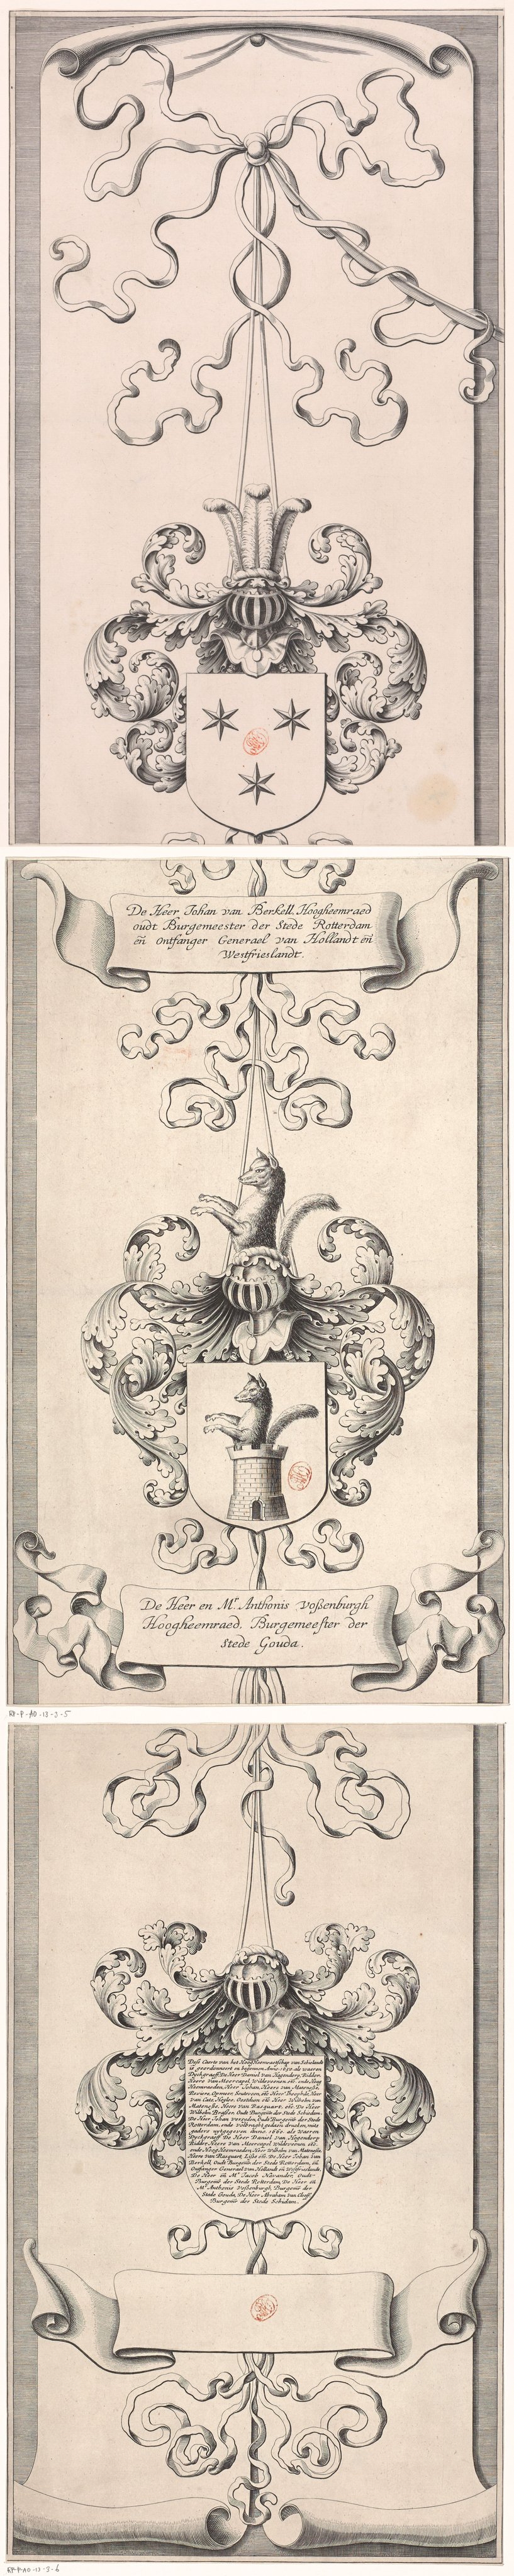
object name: print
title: Rechter wapenrand van een kaart van het Hoogheemraadschap van Schieland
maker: johannes vinckboons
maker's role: draughtsman, print maker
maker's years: 1616-1670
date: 1660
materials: paper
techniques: engraving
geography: amsterdam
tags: rotterdam, mayor, armorial bearing, heraldry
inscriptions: collector's mark: Lugt 195, collector's mark: Lugt 2228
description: Dit object is omwille van een betere presentatie virtueel samengevoegd maar bestaat fysiek uit losse onderdelen. Dit geheel vormt de rechter wapenrand van de eerste druk (1660) van 'Het Hooge Heemraedtschap van Schielandt', een negendelige kaart van het hoogheemraadschap van Schieland. Van deze kaart zijn voor zover na te gaan zes verschillende drukken bekend, uit respectievelijk 1660, 1684, 1694, 1710, 1718 en 1765. Het hoogheemraadschap gaf in 1650 opdracht tot het maken van de kaart. De wapens van de toen zittende dijkgraaf, vijf hoogheemraden en rentmeester/secretaris staan daarom op de kaart, die echter pas in 1660 werd voltooid en voor het eerst uitgegeven. Slechts de dijkgraaf en één hoogheemraad zaten toen nog in het bestuur. Vermoedelijk werd daarom bij de eerste druk een wapenrand met de wapens en namen van de vier overige hoogheemraden en de rentmeester/secretaris en een schild met alle namen van de dijkgraaf en hoogheemraden uit 1650 en 1660 toegevoegd. De huidige object is de rechter wapenrand van deze eerste druk. Voor de tweede druk van de kaart werd slechts één plaat bijgewerkt. Verondersteld wordt dat vervolgens voor de derde, vierde en vijfde druk de platen onveranderd bleven. Wel werd voor iedere uitgave een nieuwe wapenrand gedrukt met de wapens en namen van de toen zittende bestuursleden van het hoogheemraadschap. In 1765 werden de platen van de kaart, op één na, allen bijgewerkt. Voor de linker wapenrand, zie RP-P-AO-13-3Y. Voor een exemplaar van de tweede (1684), derde (1694), vierde (1710) of vijfde (1718) druk van de kaart, zie RP-P-AO-13-3X.